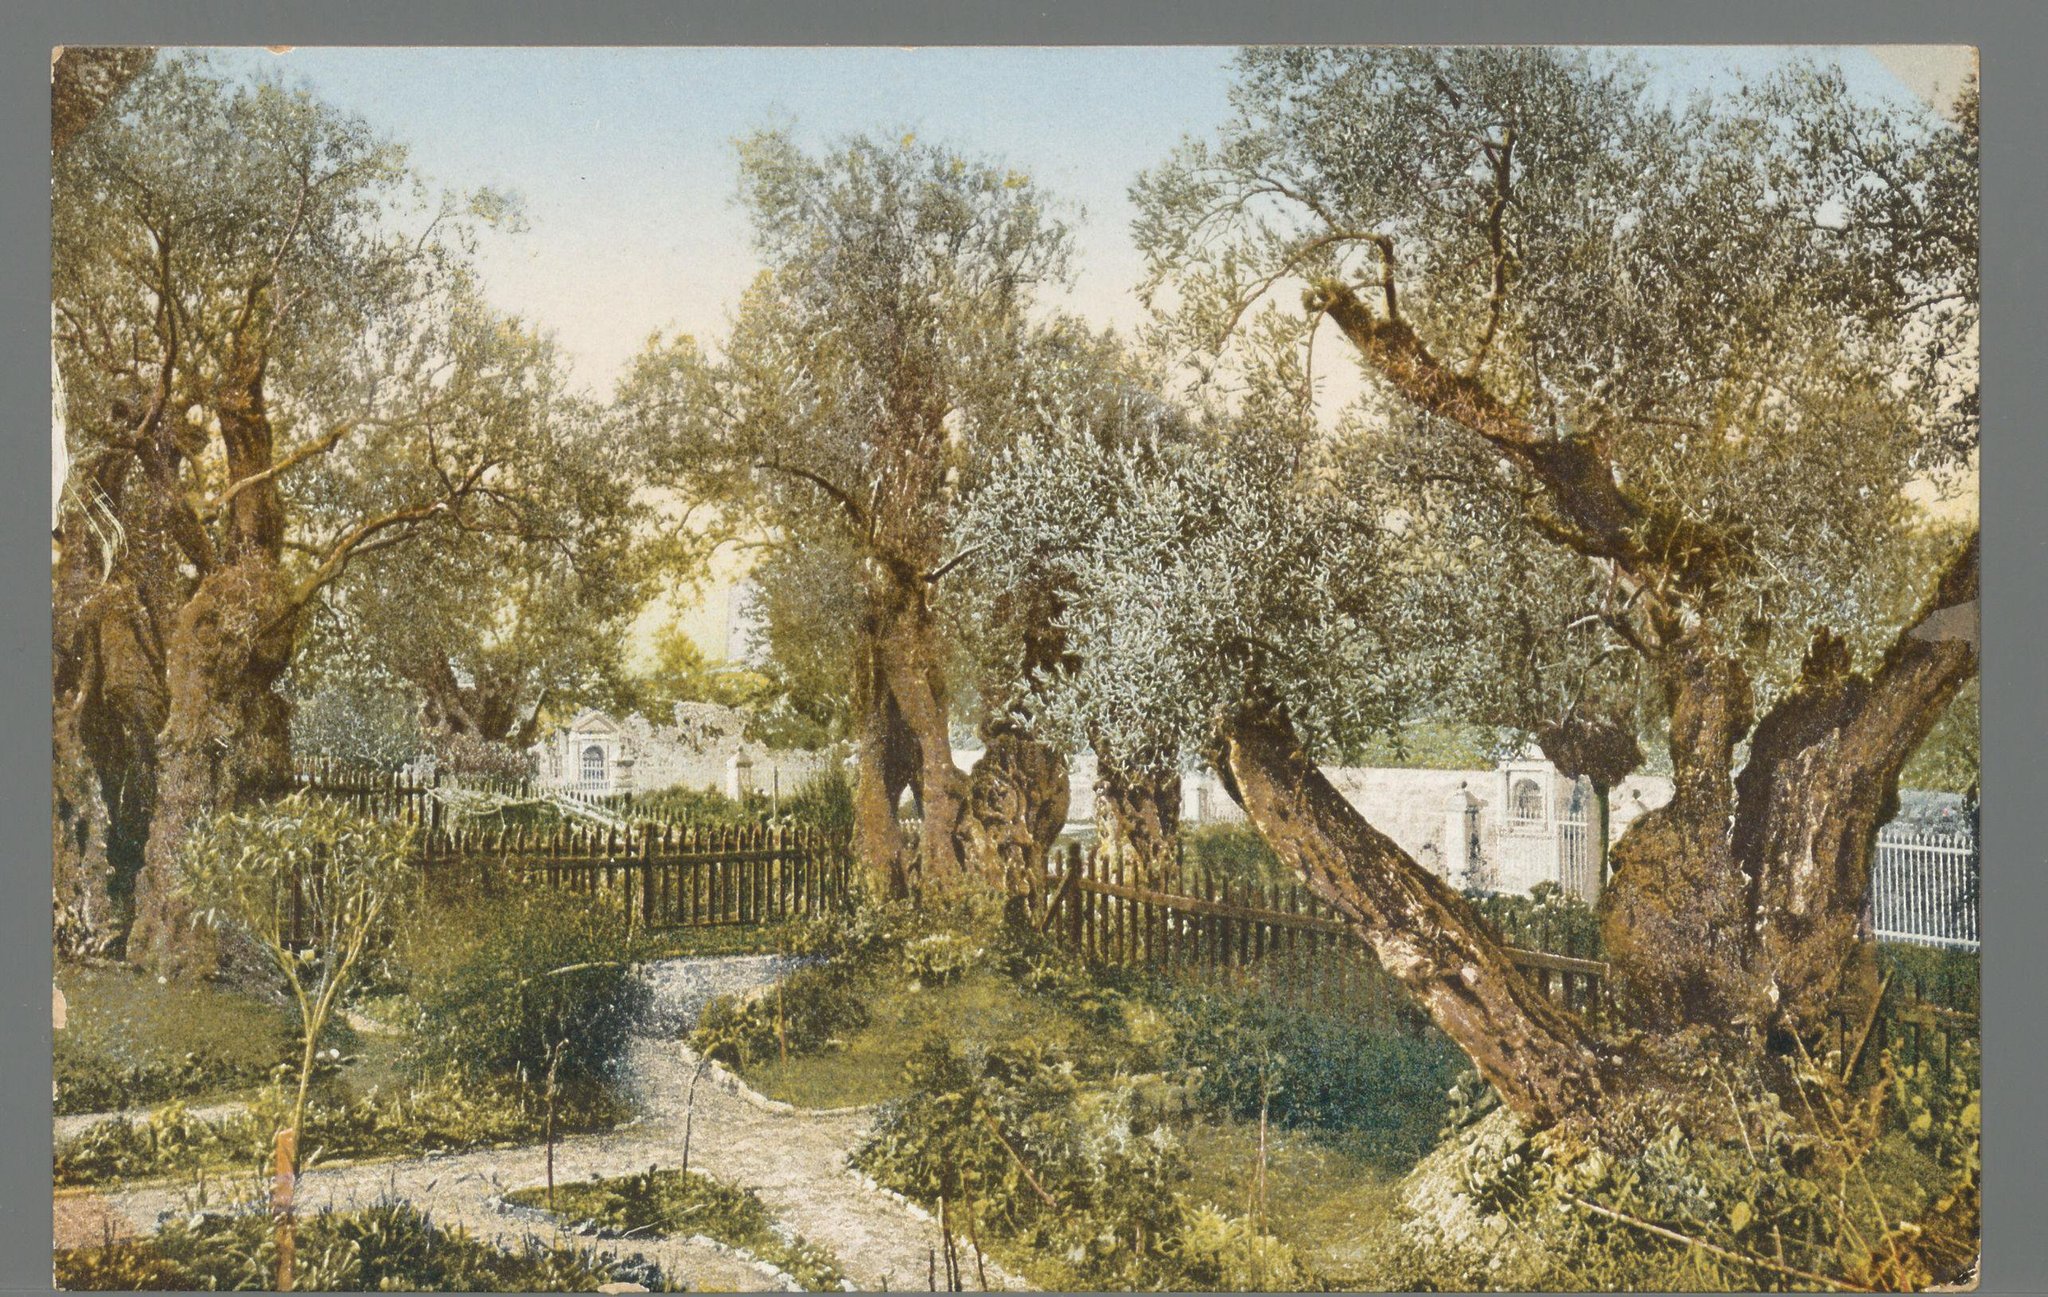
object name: photomechanical print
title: Jérusalem - Jardin de Gethsémani / Jerusalem - The Garden of Gethsemane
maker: Anonymous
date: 1905-1930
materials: cardboard, photographic process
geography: zurich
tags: garden